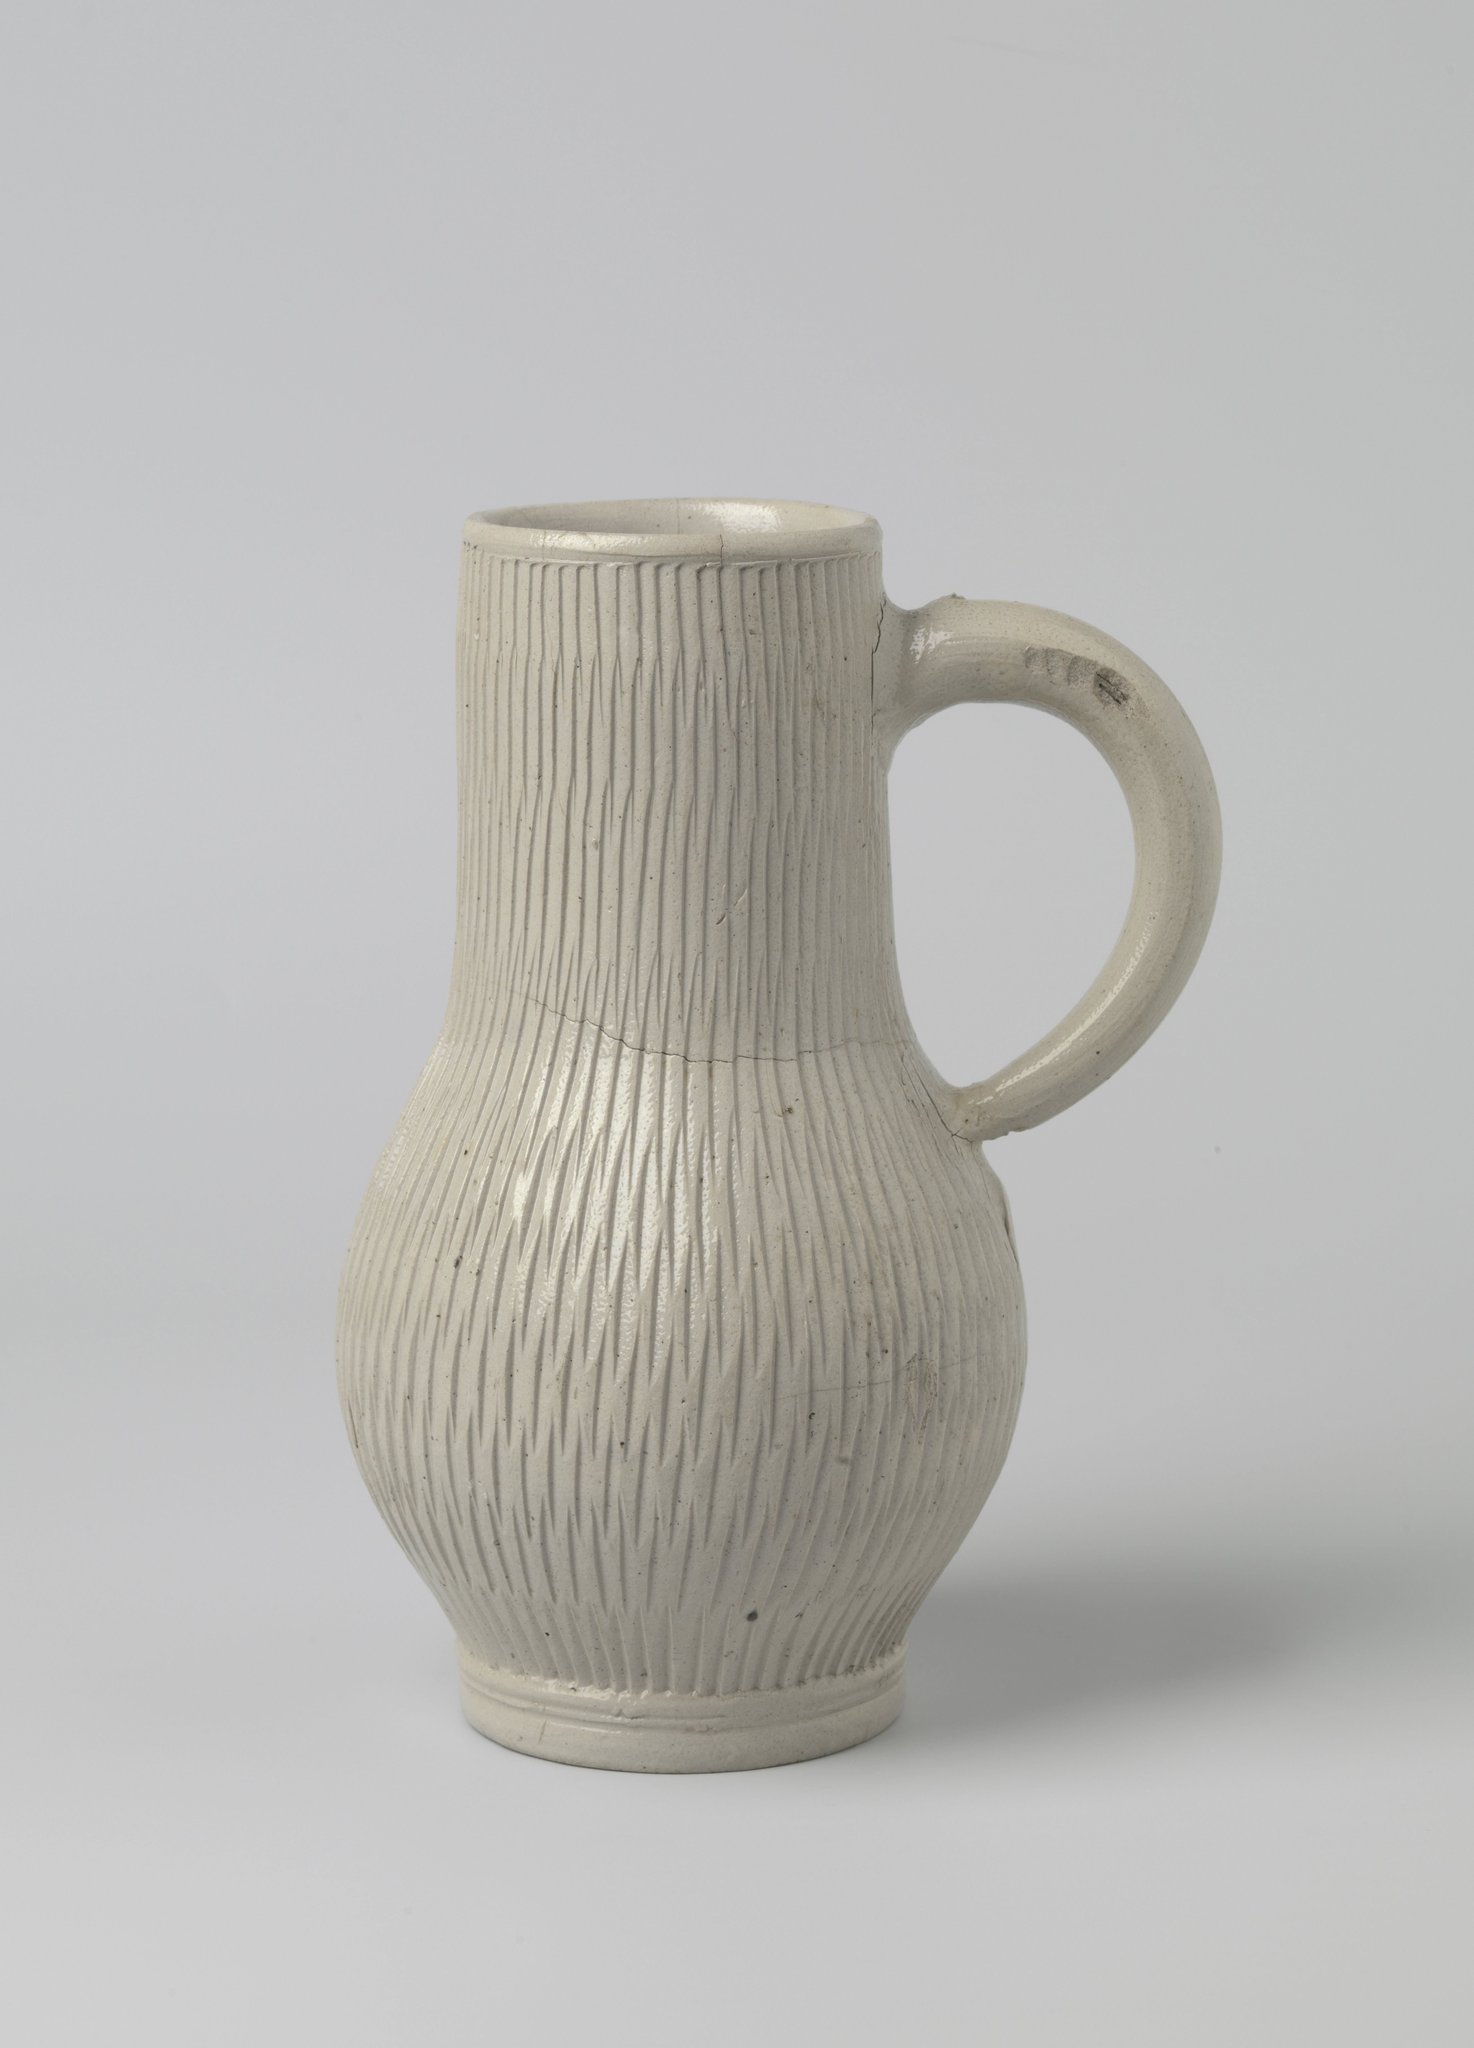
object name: jug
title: Chip-carved jug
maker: Anonymous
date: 1750-1780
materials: glaze, stoneware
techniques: firing, forming, turning, vitrification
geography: westerwald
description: Kruik van steengoed op standring met een bolvormige buik en wijde nek. Het C-vormige oor is bevestigd aan de nek en de schouder. De kruik is geheel versierd met kerfsnede. Westerwald.